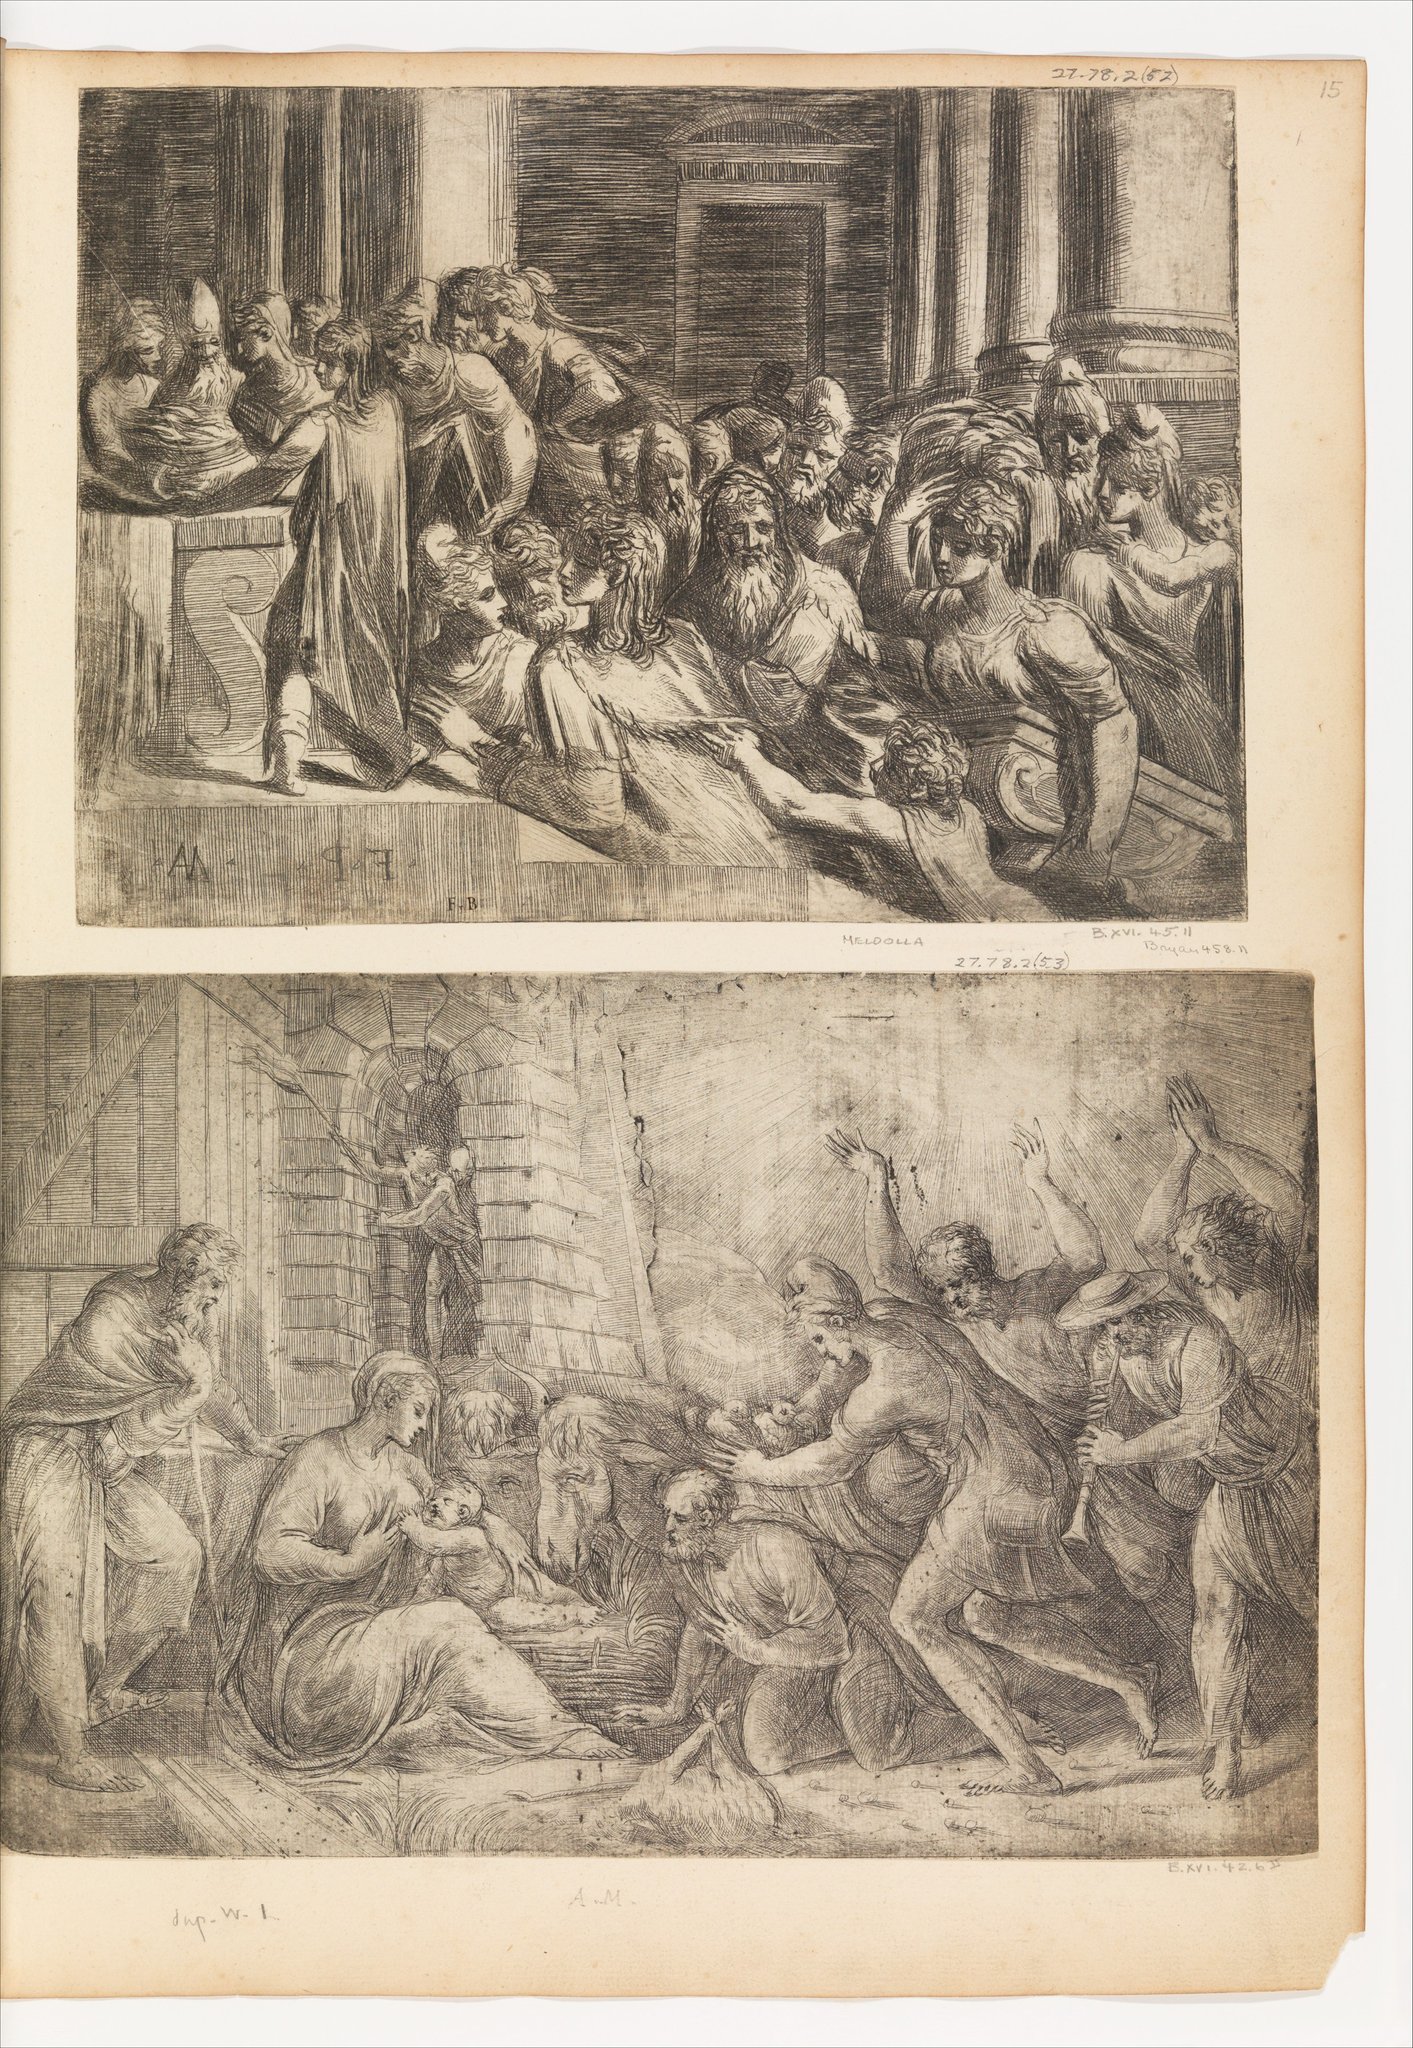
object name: print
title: The Nativity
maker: andrea schiavone (andrea meldola)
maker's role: artist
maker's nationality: italian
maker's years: 1510-1563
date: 1558-1560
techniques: etching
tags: men,women,nativity